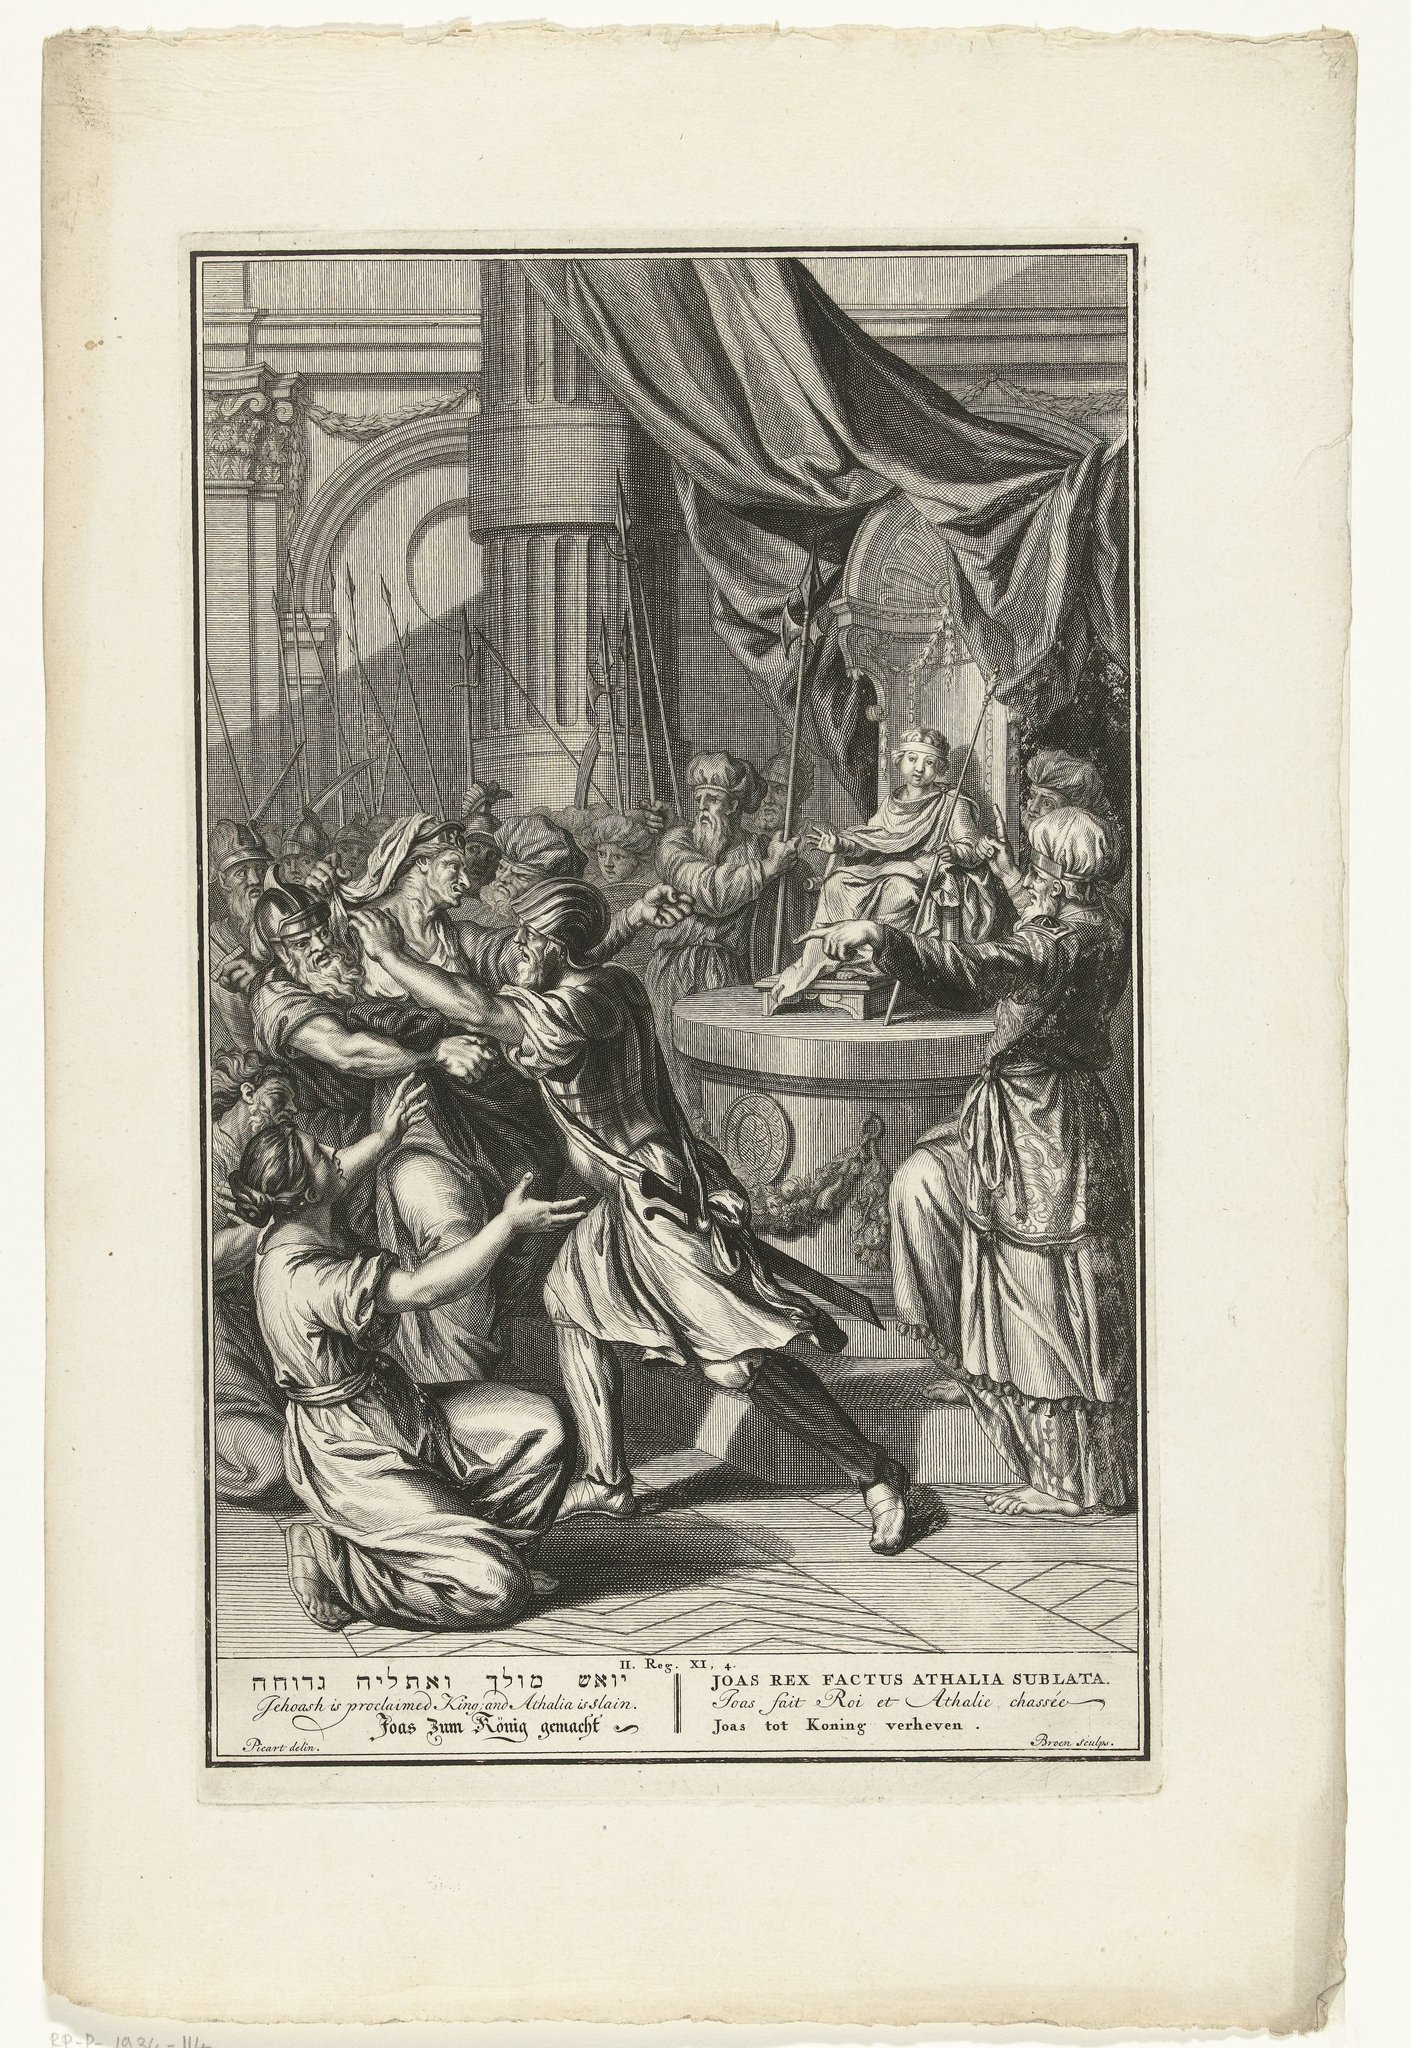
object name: book illustration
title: Atalja en Joas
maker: bernard picart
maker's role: draughtsman, print maker, publisher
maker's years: 1673-1733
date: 1711-1720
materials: paper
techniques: engraving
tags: joash is proclaimed king at the age of seven, athalia hearing the noise of the people acclaiming king joash, comes to the temple and sees the new king standing by a pillar; she tears her clothes in dismay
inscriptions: inscription: ‘Utrechts Fundatie huys’, collector's mark: Lugt 2228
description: De hogepriester Jojada verheft de jongen Joas tot koning. Zijn grootmoeder Atalja probeert hem te doden en wordt door de paleiswachten gevangen genomen. Illustratie voor het Oude Testament, 2 Kon. 11. Onder de voorstelling een titel in het Hebreeuws, Engels, Duits, Latijn, Frans en Nederlands.